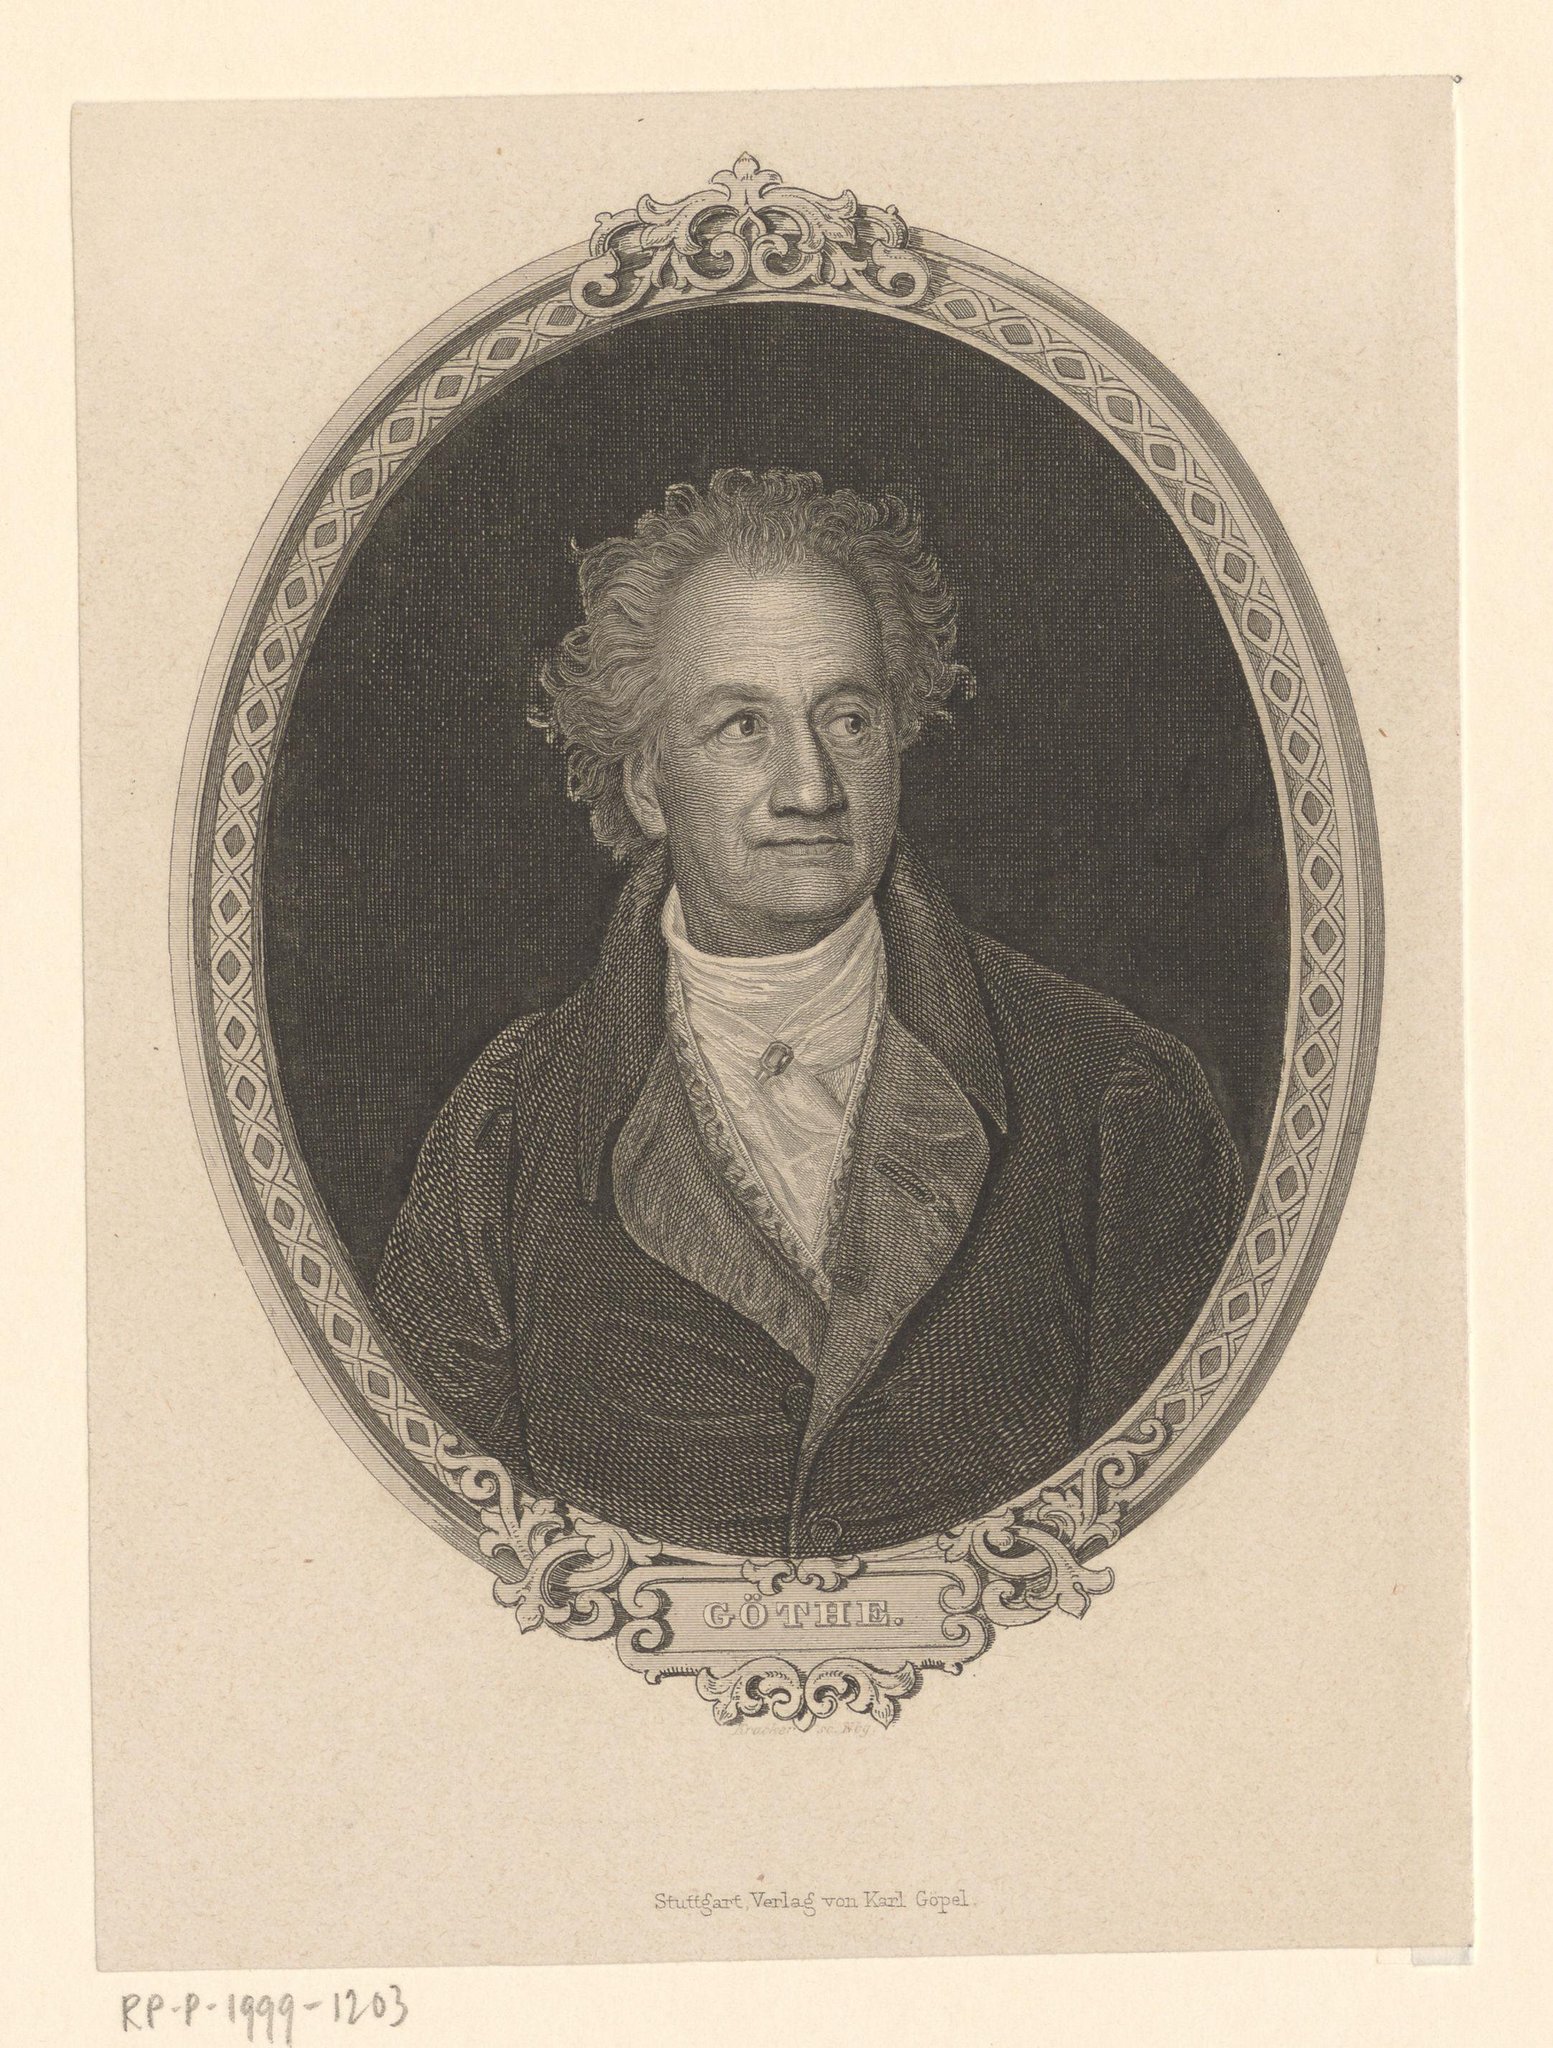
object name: print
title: Portret van Goethe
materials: paper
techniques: engraving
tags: draughtsman, johann wolfgang von goethe, historical persons